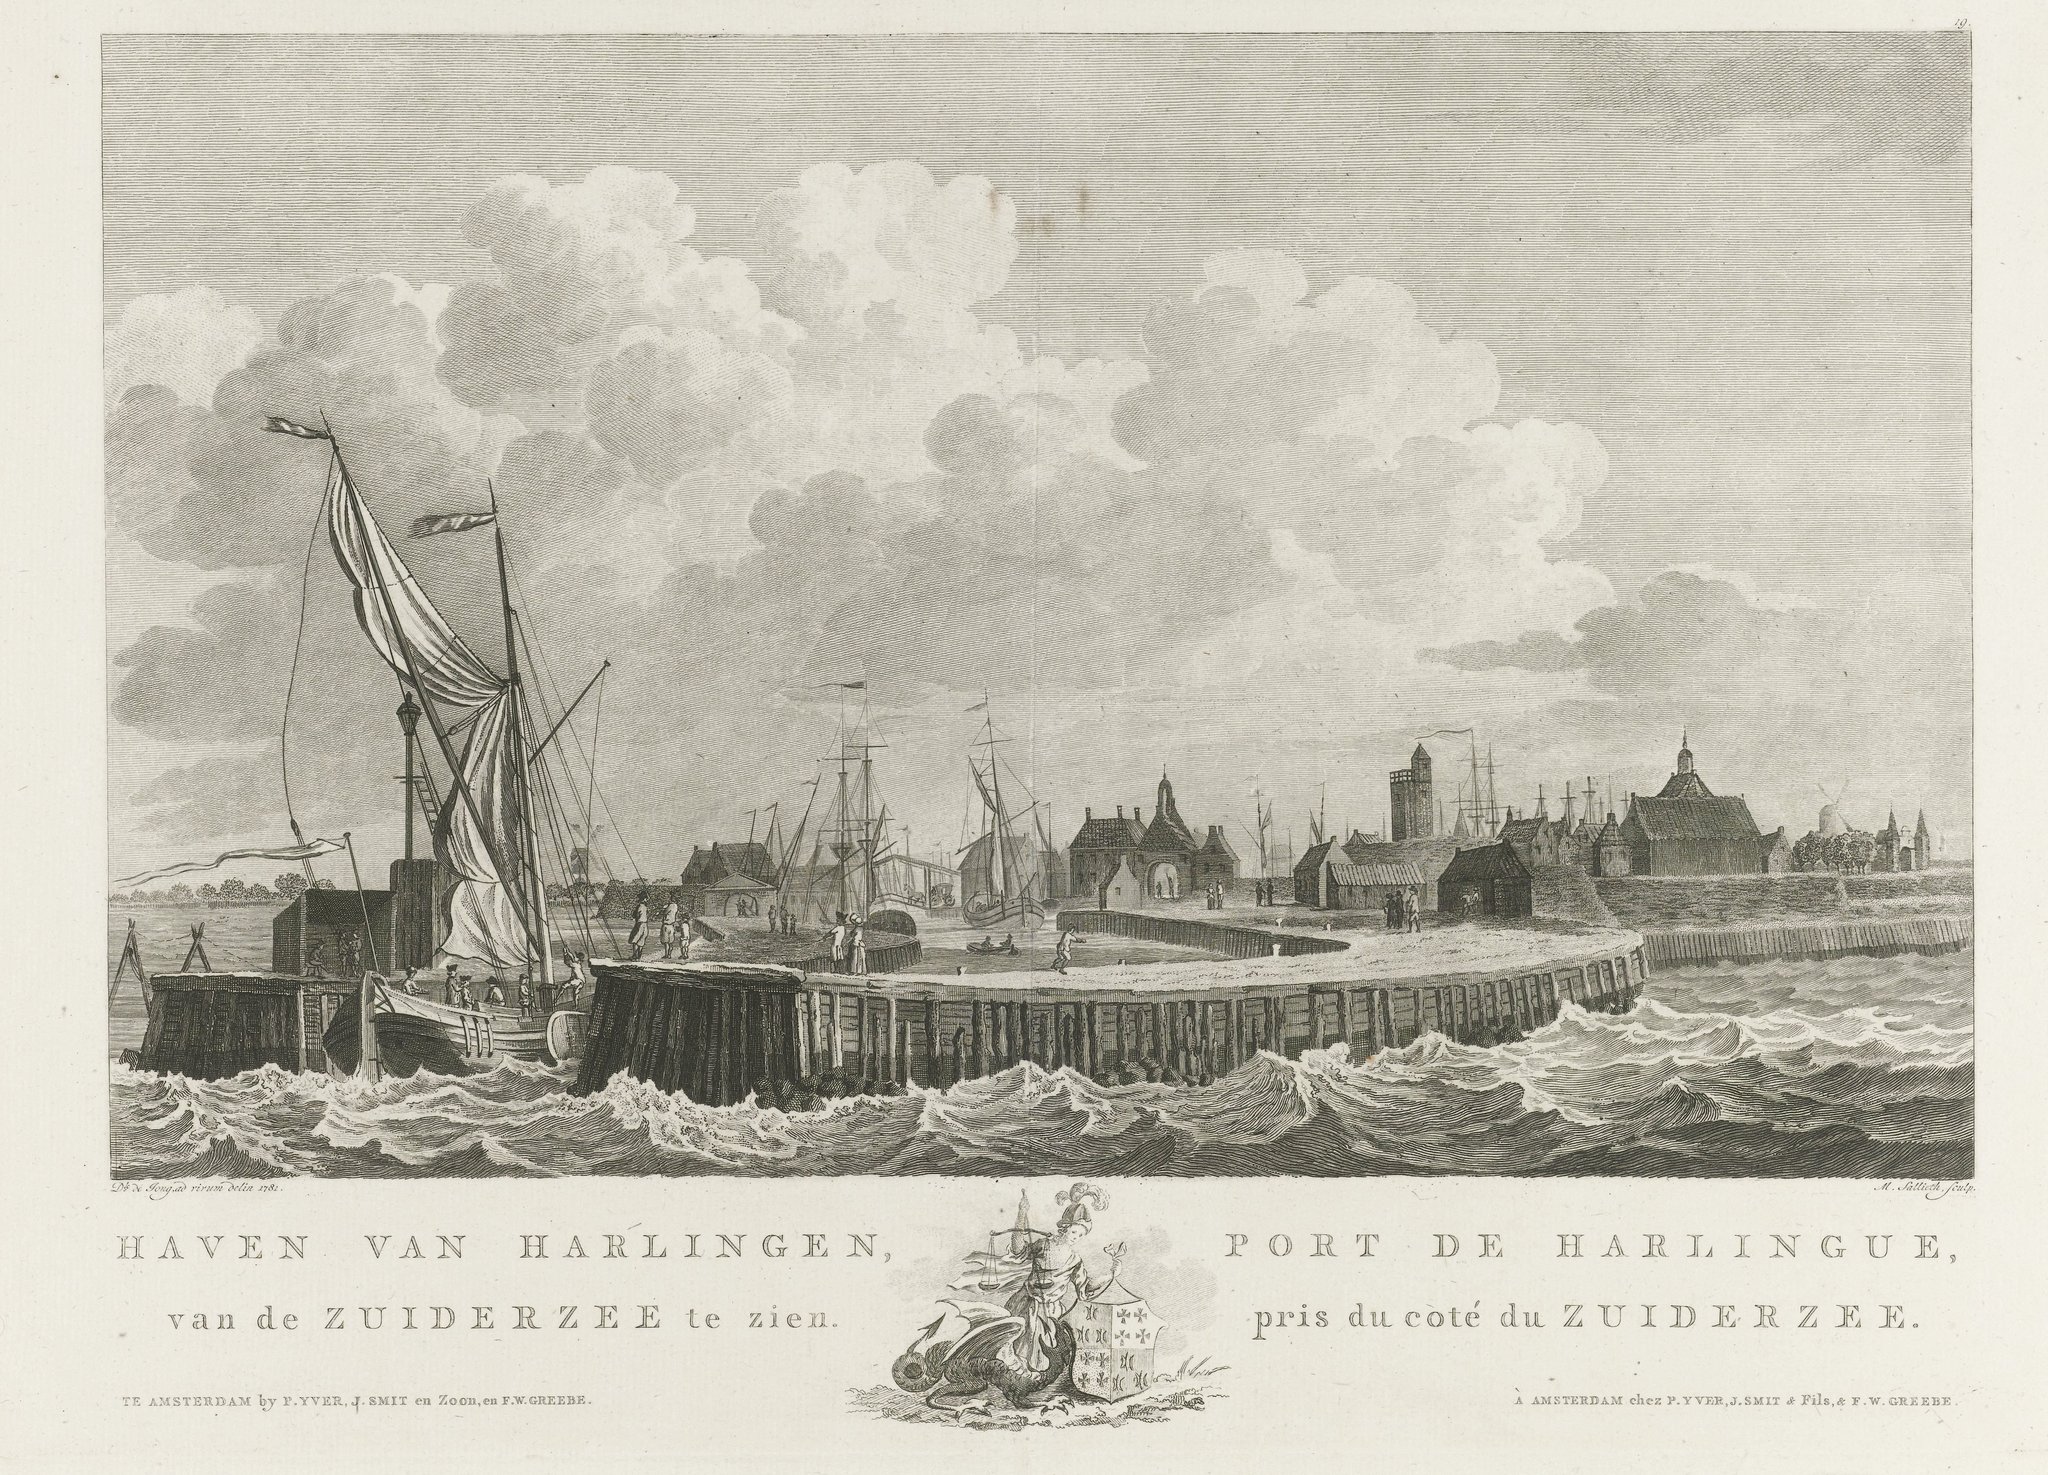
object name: print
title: Haven van Harlingen, van de Zuiderzee te zien / Port de Harlingue, pris du coté du Zuiderzee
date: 1781-1787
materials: paper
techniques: etching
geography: amsterdam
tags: harbour, coat of arms (as symbol of the state, etc.) (+ city; municipal), sailing-ship, sailing-boat, harlingen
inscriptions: collector's mark: Lugt 2228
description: De haven van Harlingen, gezien vanaf de Zuiderzee. In de marge het wapen van de stad. Prent rechtsboven genummerd: 19.